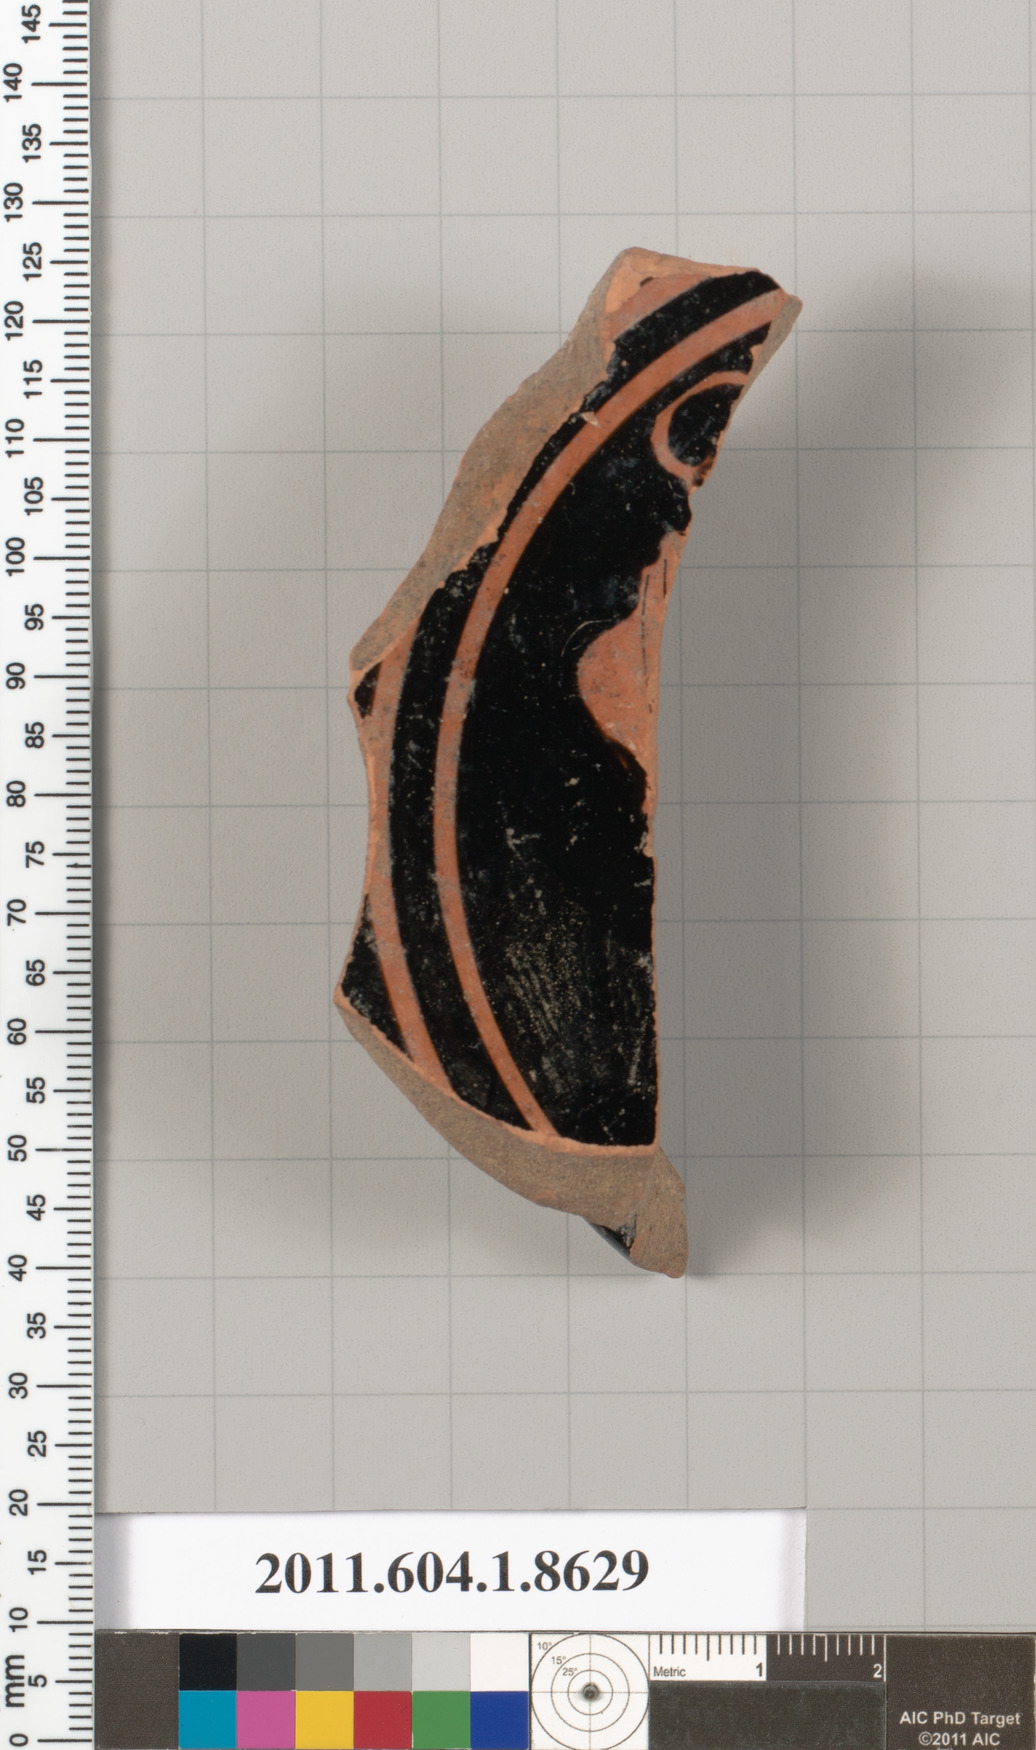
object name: kylix fragment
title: Terracotta fragment of a stemless kylix (drinking cup)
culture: greek, attic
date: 467-435 BCE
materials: terracotta